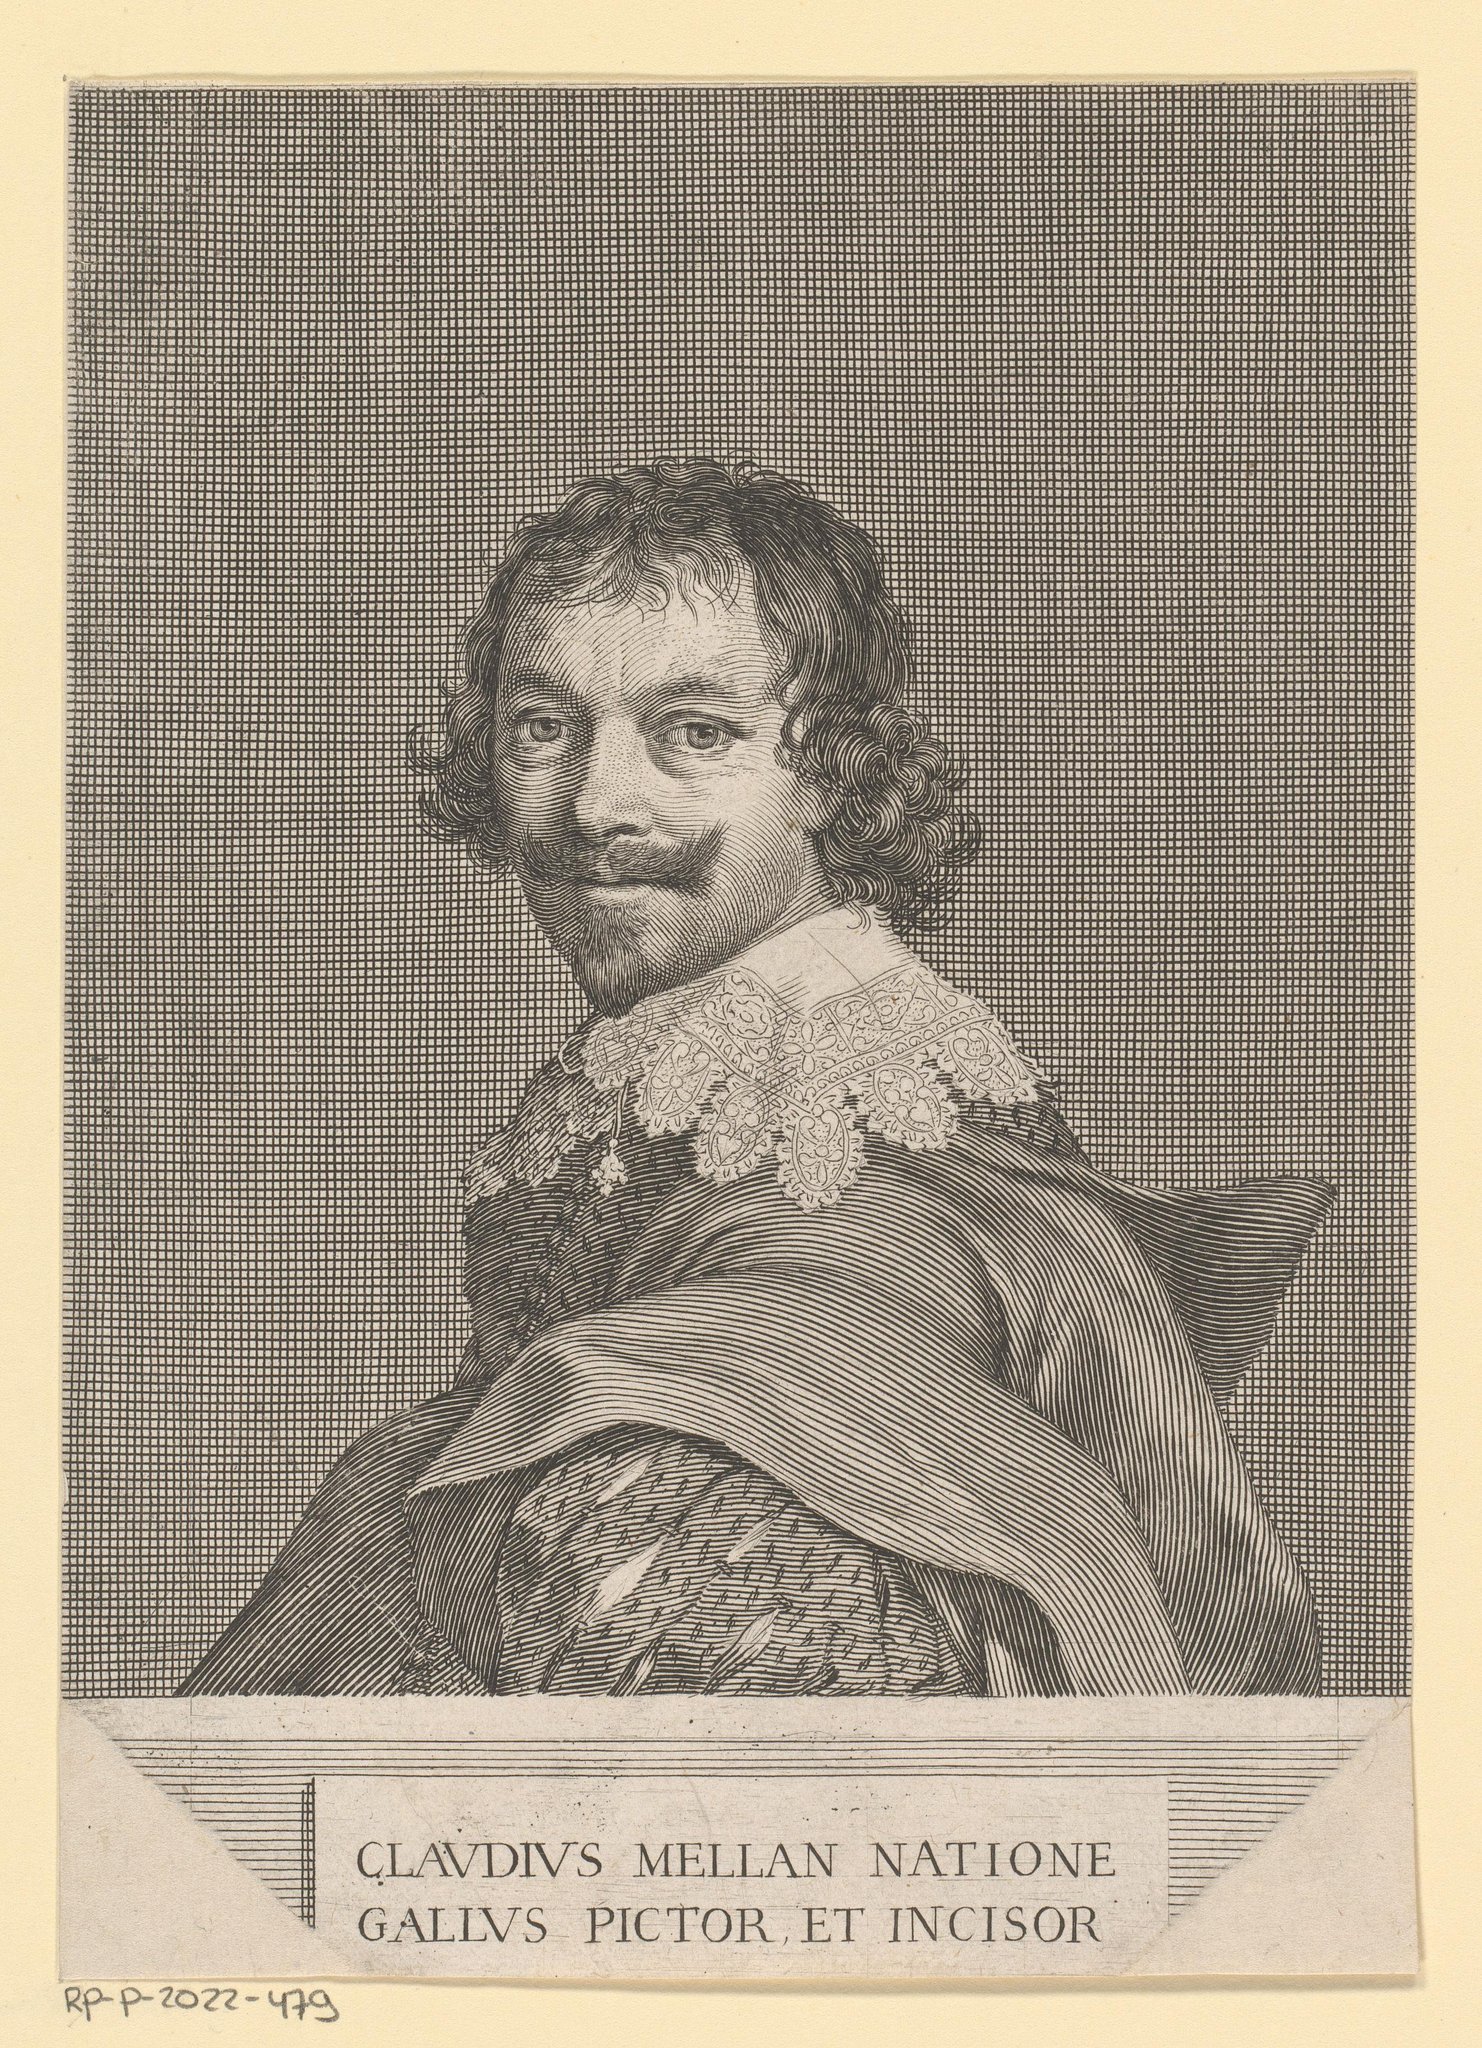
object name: print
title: Zelfportret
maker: claude mellan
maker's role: draughtsman, print maker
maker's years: 1598-1688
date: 1635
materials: paper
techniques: engraving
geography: rome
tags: claude mellan, historical persons, portrait, self-portrait of graphic artist